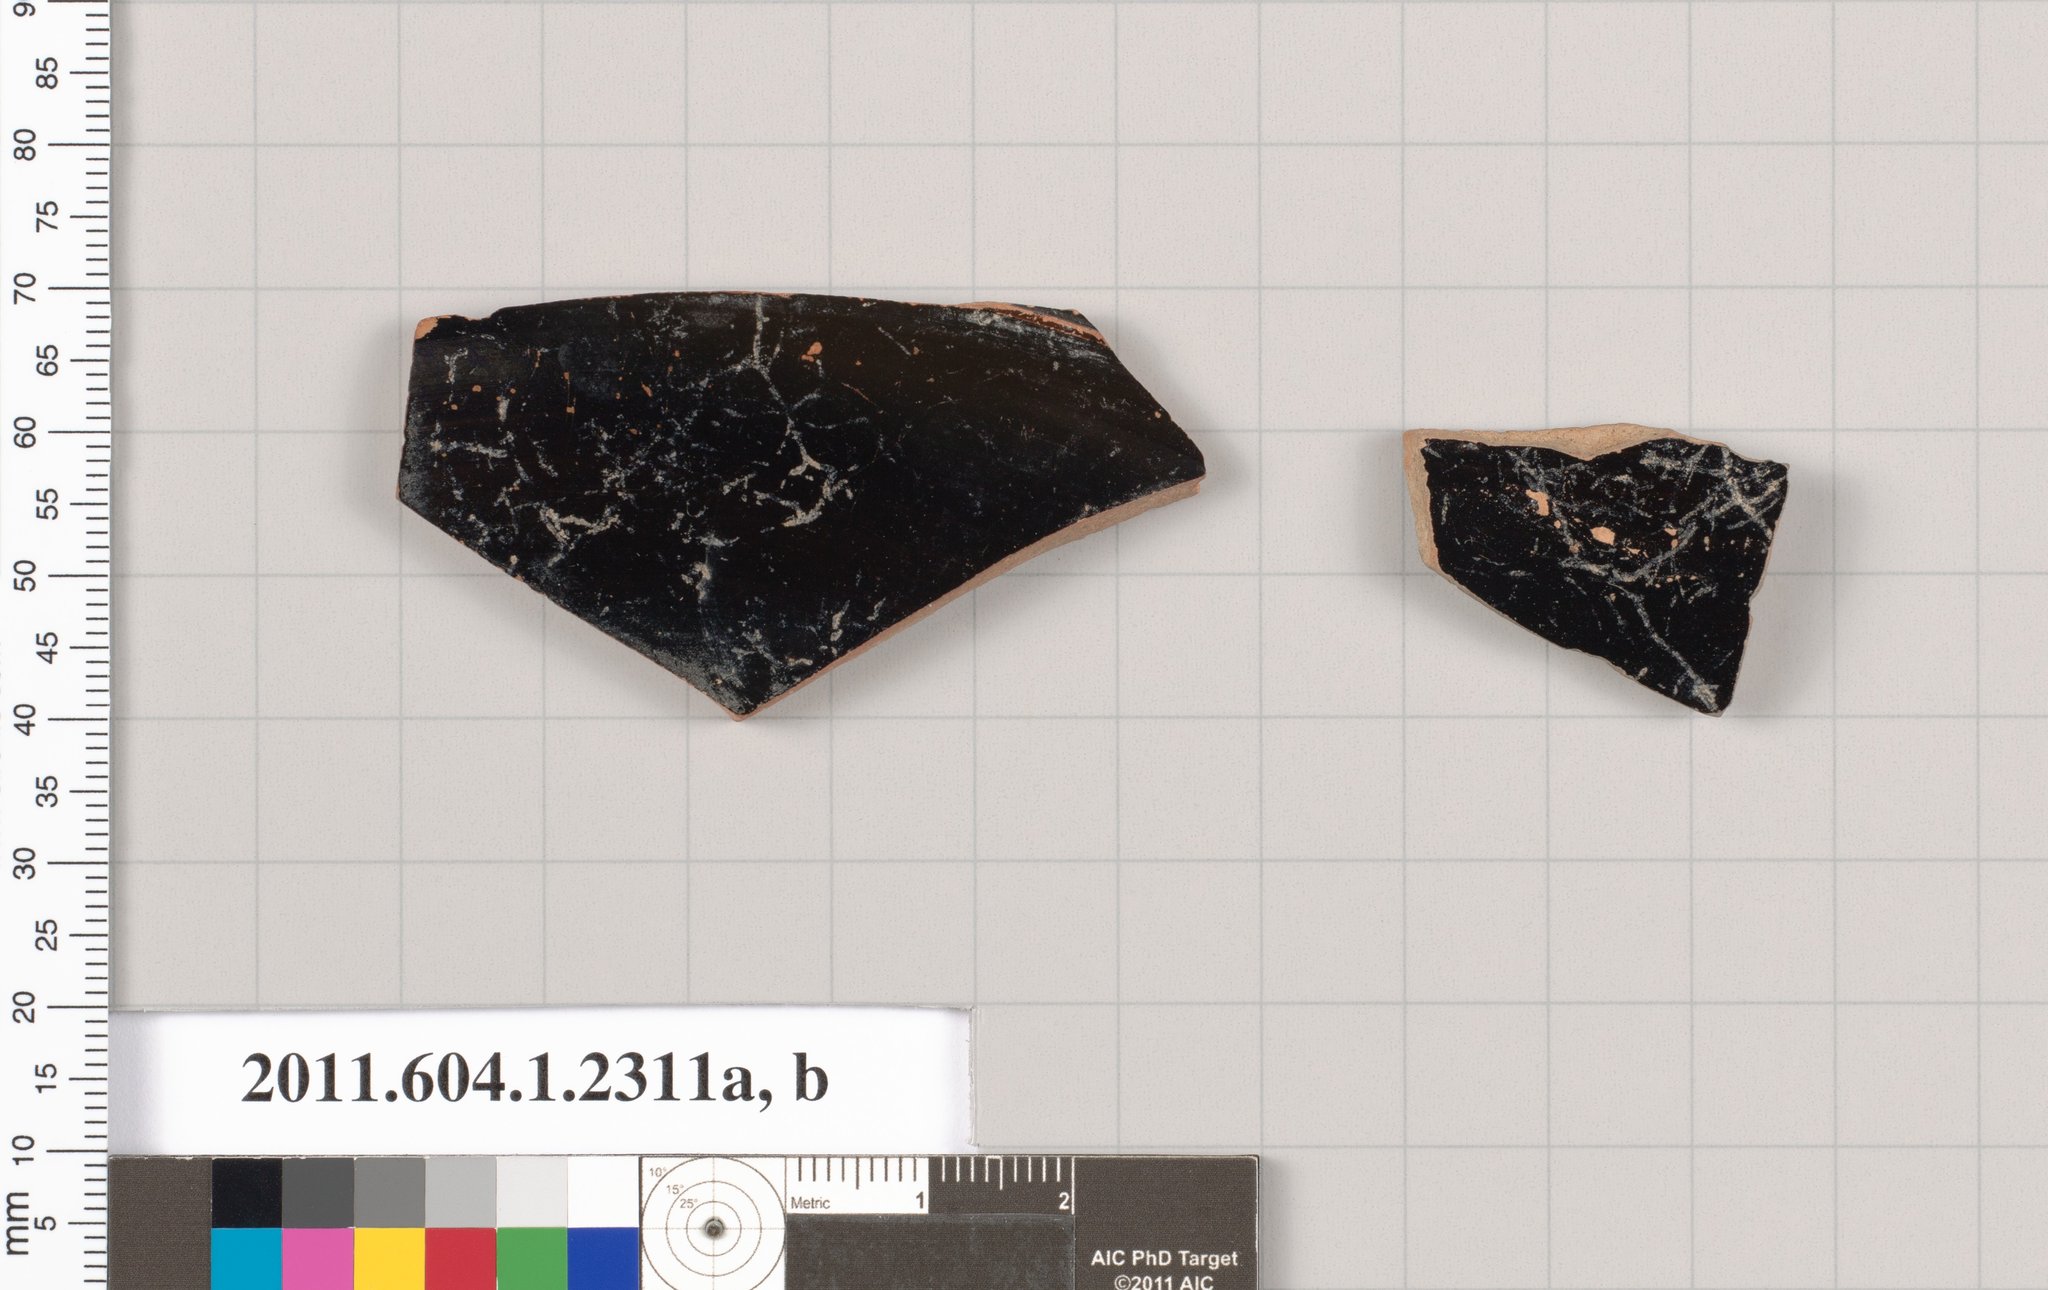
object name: kylix fragment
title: Terracotta fragments of kylikes(drinking cups)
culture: greek, attic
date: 500-451 BCE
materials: terracotta